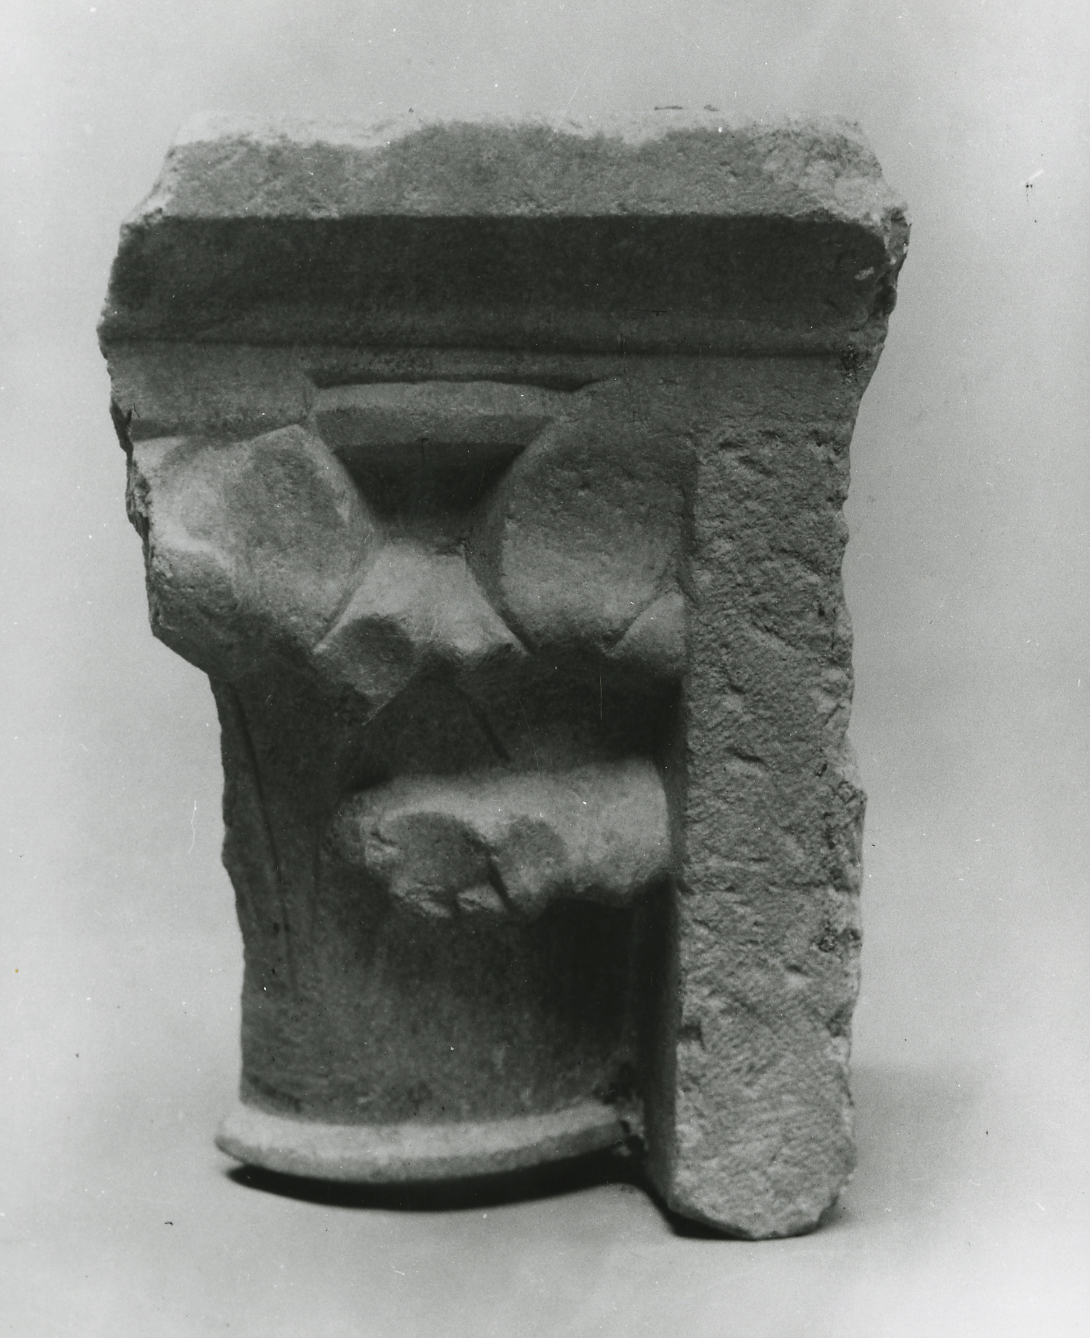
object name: capital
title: Fragment of Double Capital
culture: french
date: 1267-1333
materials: marble